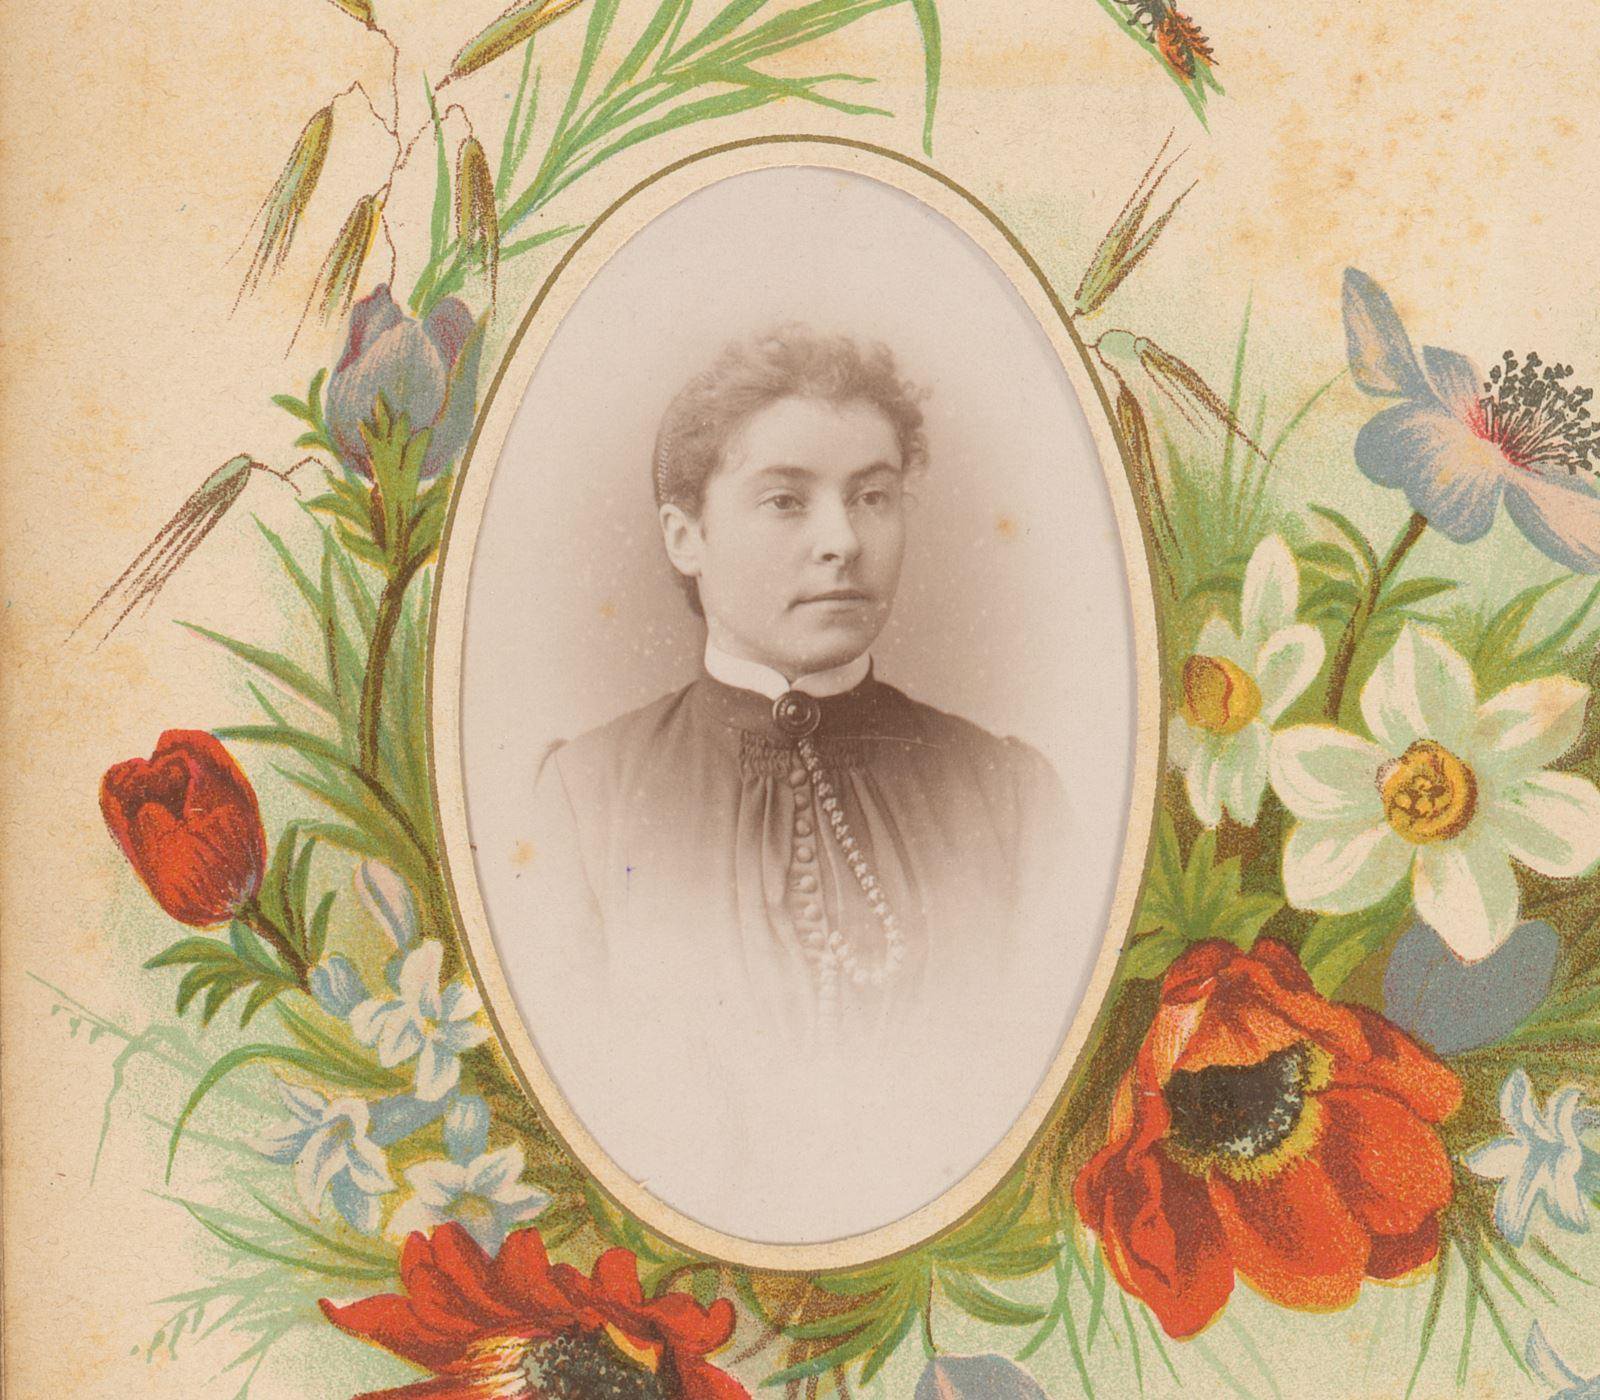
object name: album leaf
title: Portret van een vrouw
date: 1860-1900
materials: cardboard, photographic support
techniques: albumen print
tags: adult woman, historical persons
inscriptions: inscription: ‘Jenkins & Remy/ ARtist Photographers/ 7, Victoria-St. West/ Gt. Grimsby (...)’